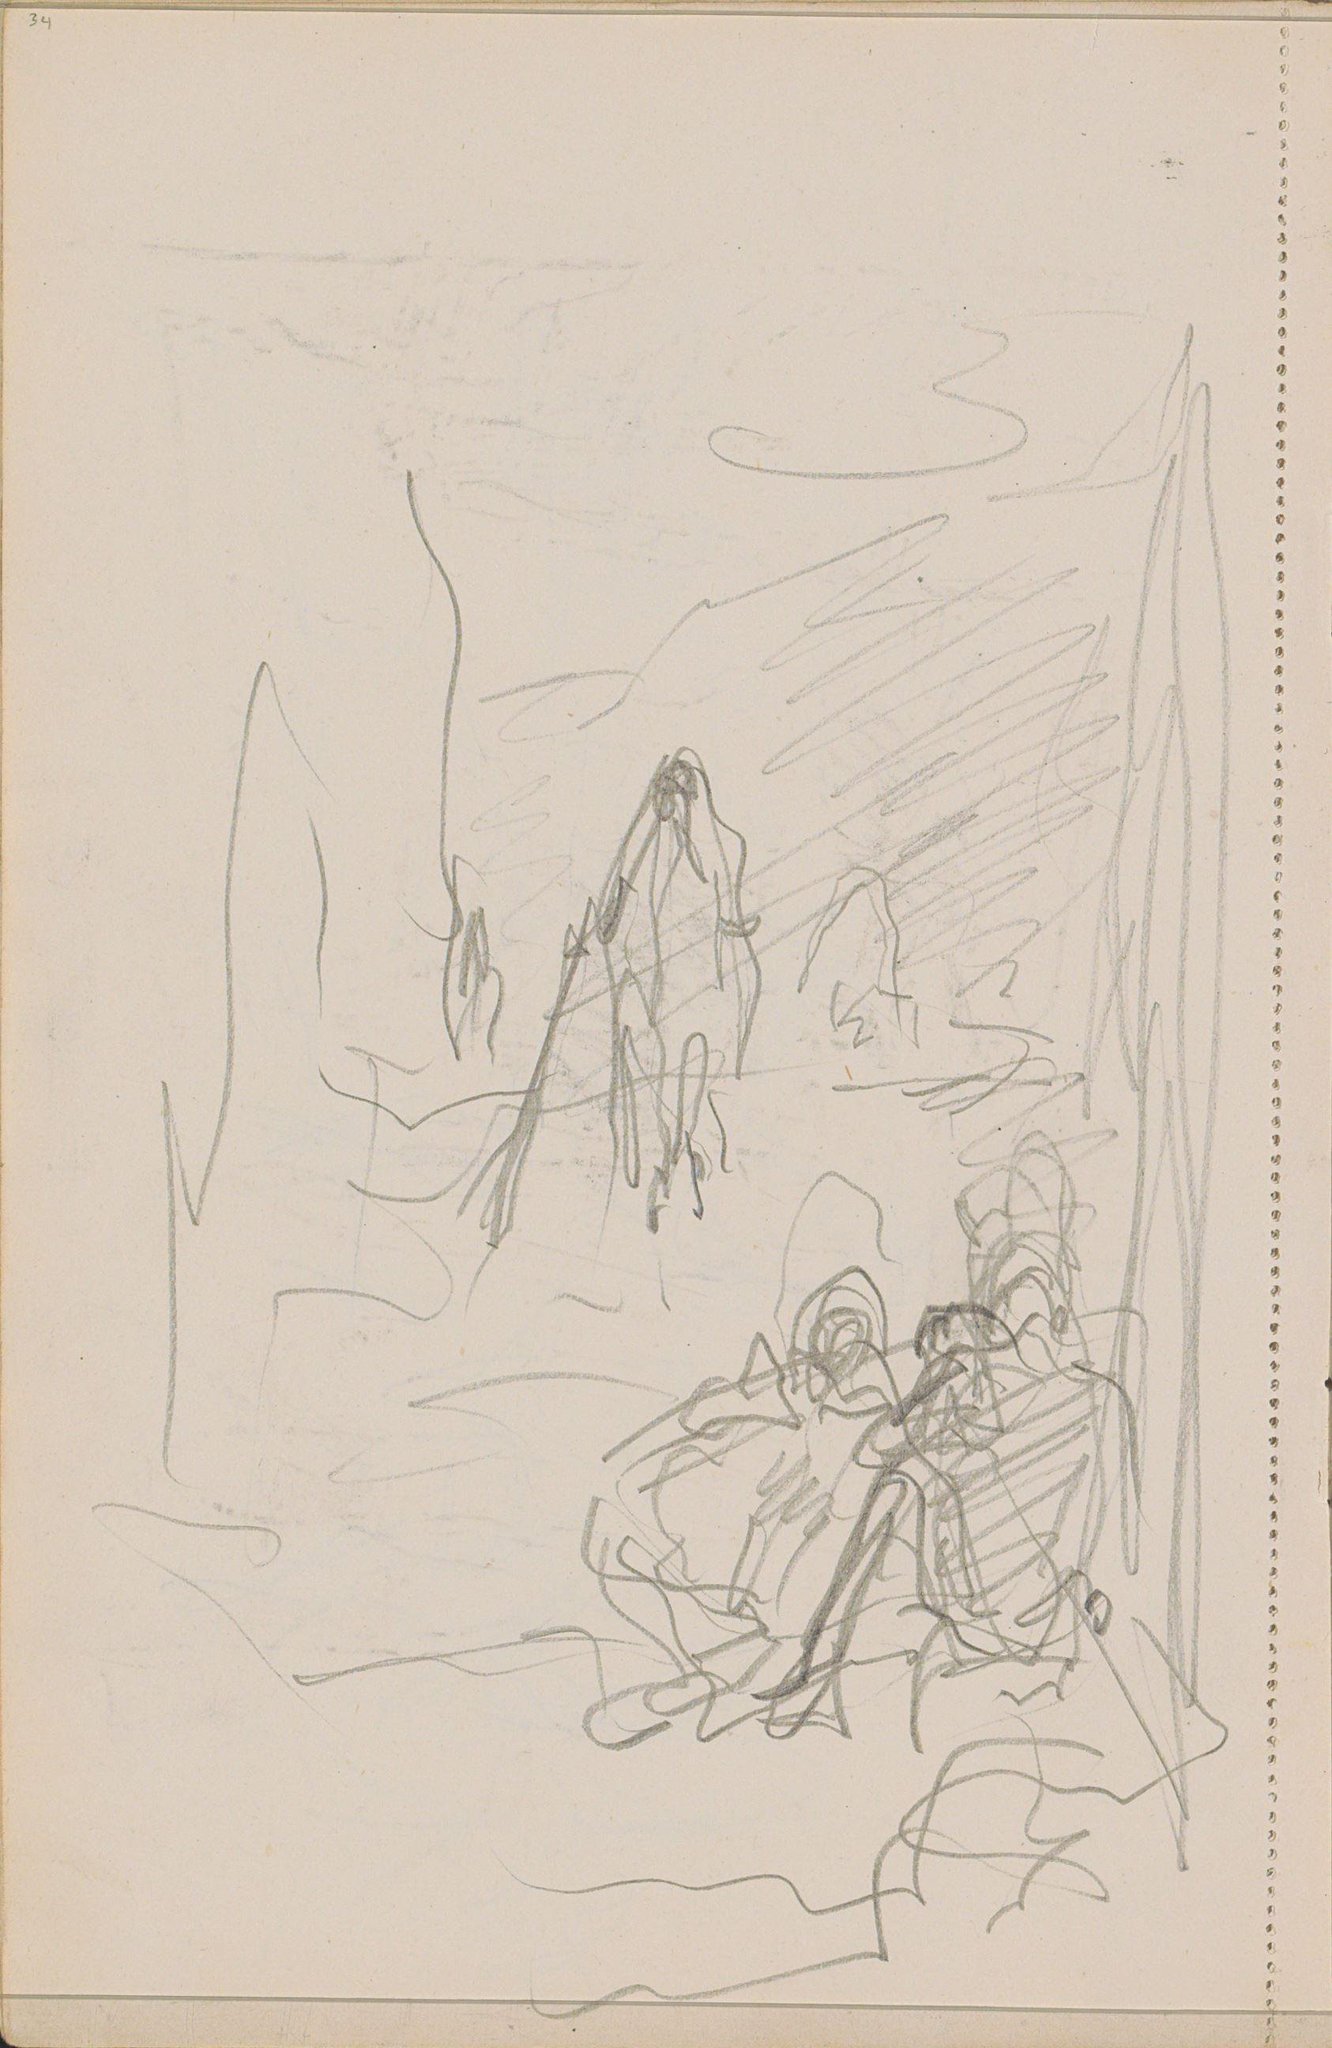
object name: sketchbook leaf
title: Straat met figuren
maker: marius bauer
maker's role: draughtsman, print maker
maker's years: 1867-1932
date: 1923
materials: paper, pencil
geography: morocco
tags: street (+ city(-scape) with figures, staffage)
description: Pagina 34 uit een schetsboek met 66 bladen.